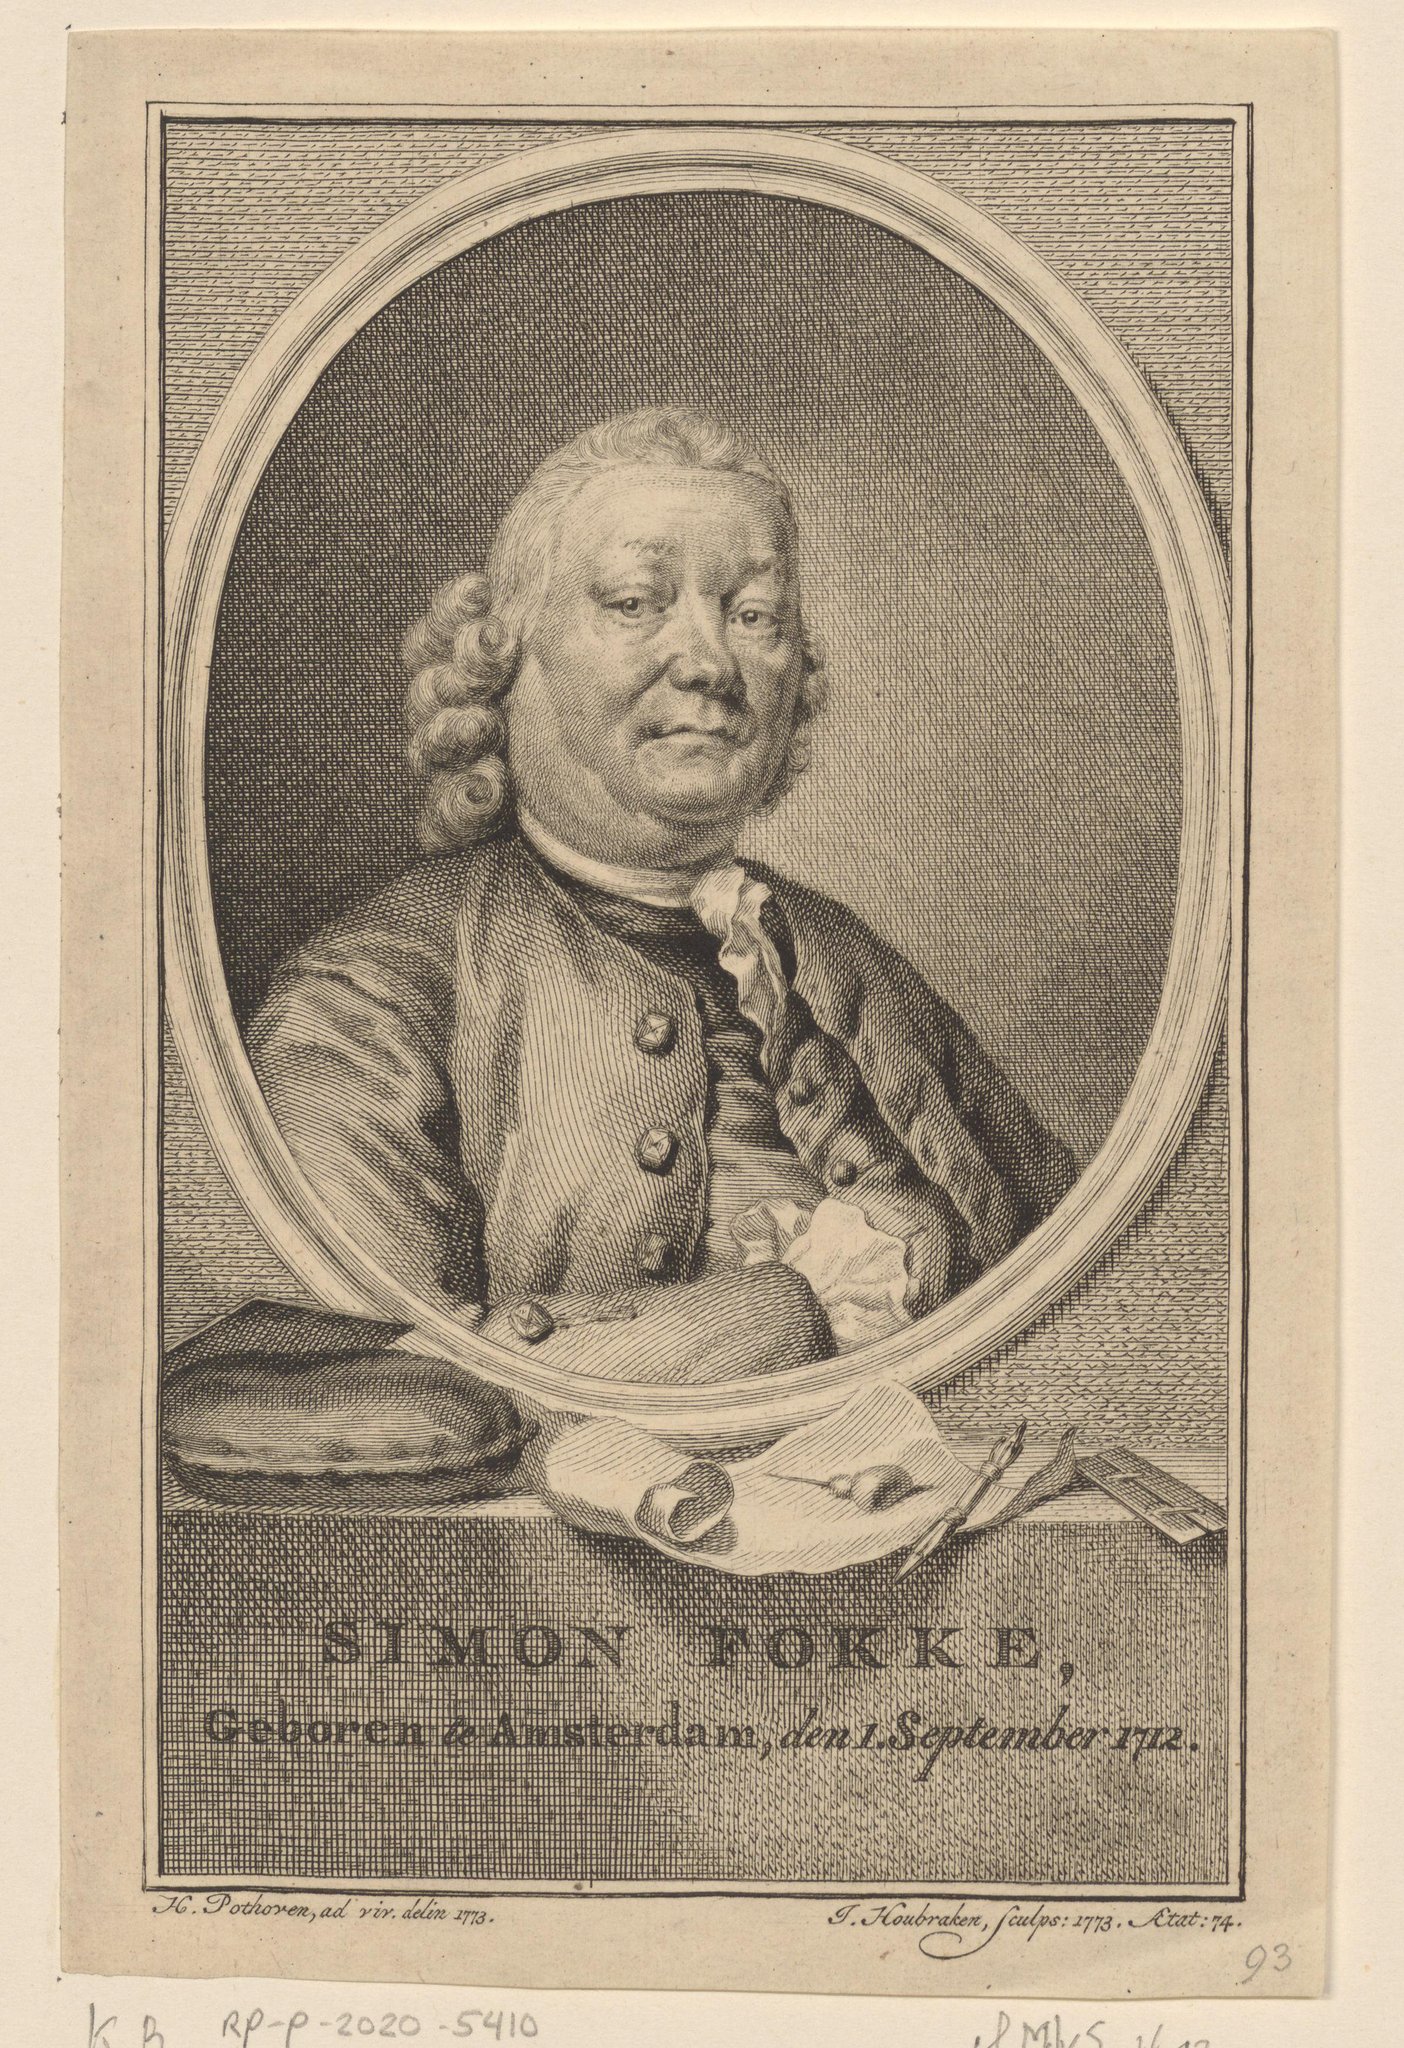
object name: print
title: Portret van Simon Fokke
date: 1773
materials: paper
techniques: engraving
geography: amsterdam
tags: amsterdam, print maker, draughtsman, simon fokke, historical persons, tools, implements of graphic artist, portrait, self-portrait of graphic artist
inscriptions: collector's mark: Lugt 240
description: Het portret rust op een plint waarop het gereedschap van de graveur ligt: burijn, koperplaat, etsnaald en papier.